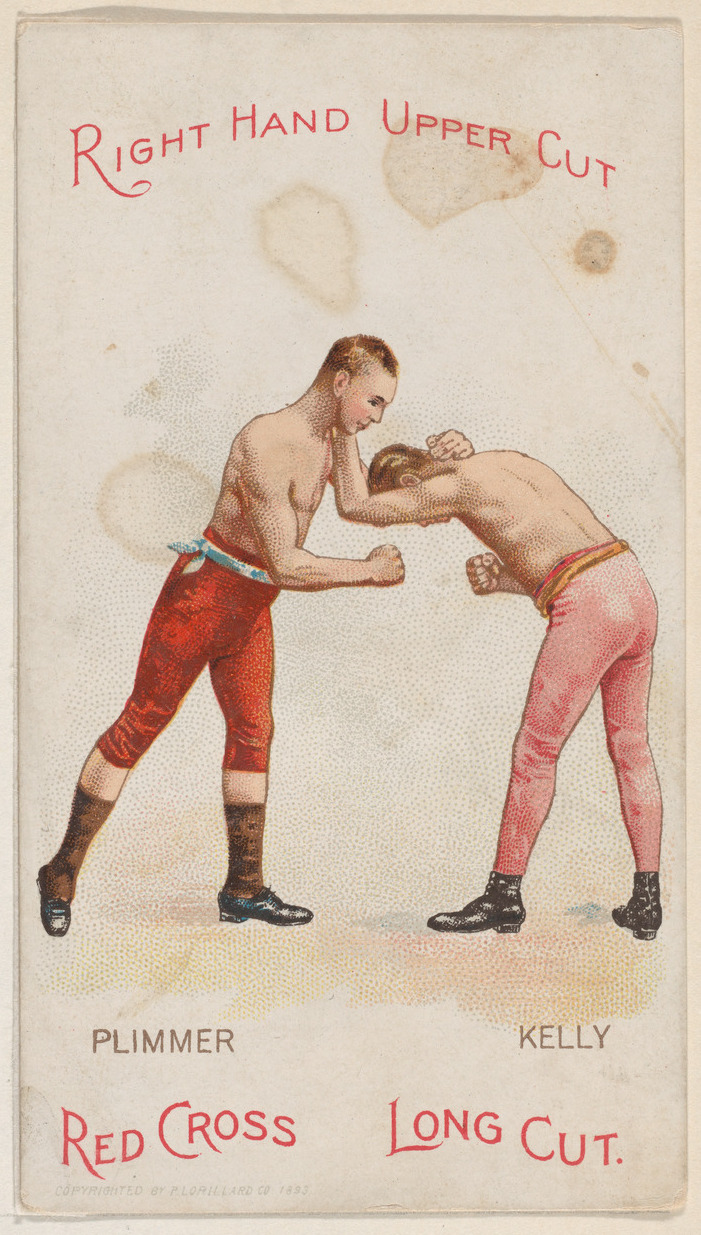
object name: print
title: Right Hand Upper Cut, Billy Plimmer and Tommy Kelly, from the Boxing Positions and Boxers series (N266) issued by P. Lorillard Company to promote Red Cross Long Cut Tobacco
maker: p. lorillard company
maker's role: publisher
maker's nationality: american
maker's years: 1760-2014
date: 1893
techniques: color lithograph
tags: men,boxing,athletes